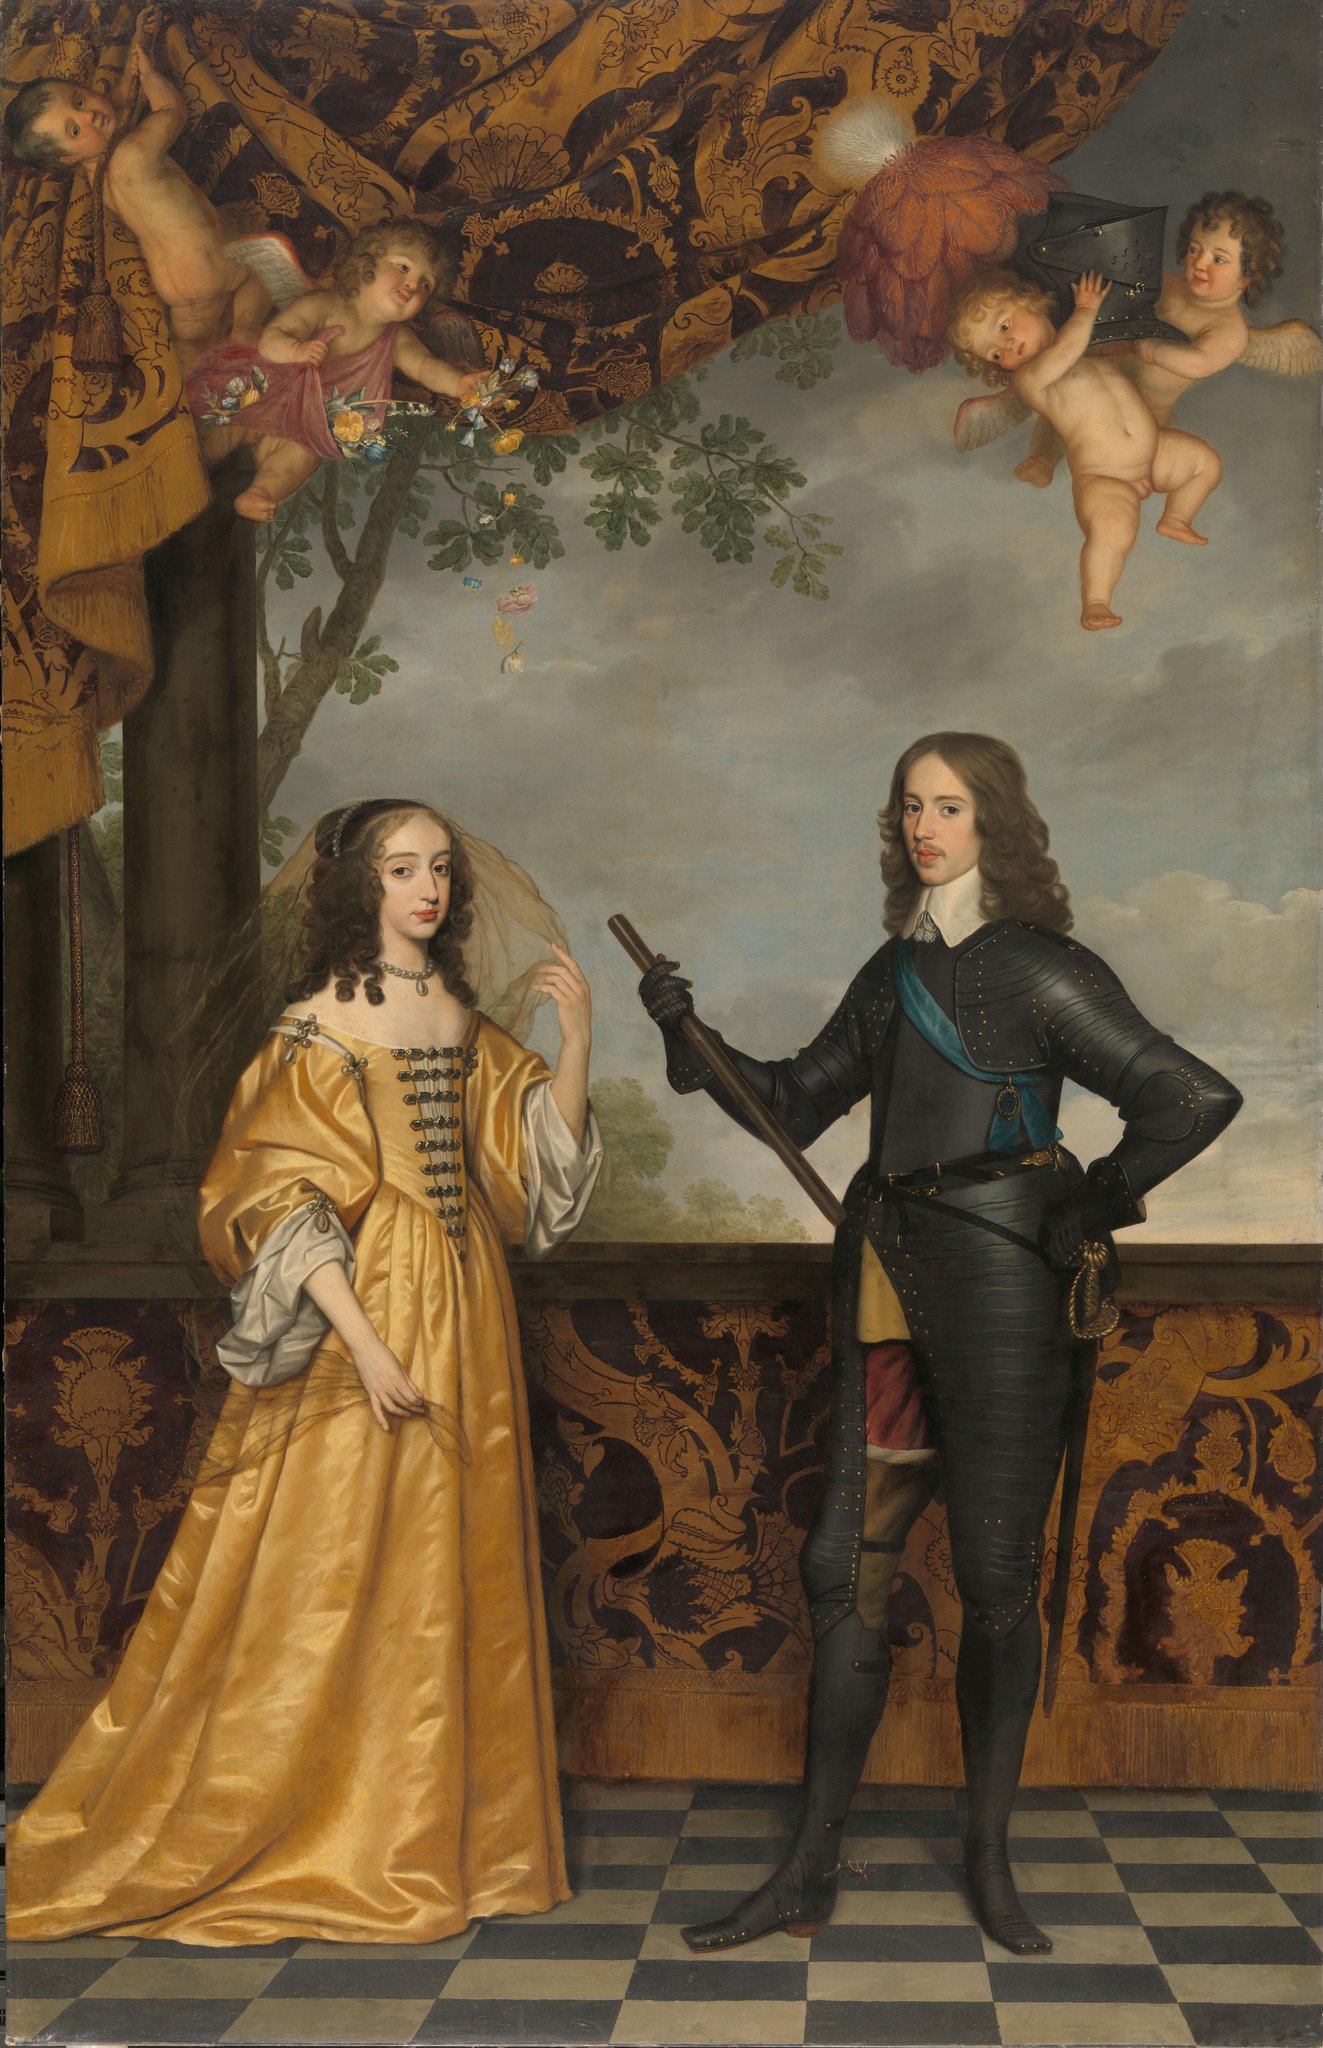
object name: painting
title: Portrait of Willem II (1626-1650), Prince of Orange, and his Wife Mary Stuart (1631-1660)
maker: gerard van honthorst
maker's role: draughtsman, painter, print maker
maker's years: 1592-1656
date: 1647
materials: canvas, oil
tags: william ii (prince of orange), mary henrietta stuart, historical persons - bb - woman, historical persons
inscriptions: signature and date, centre left, on the balustrade (G and H ligated): ‘GHonthorst / 1647’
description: Portret van Willem II, prins van Oranje, met zijn echtgenote Maria Stuart. Beiden zijn ten voeten uit voorgesteld, staande op een balkon. De prins in wapenrusting met commandostaf in de rechterhand. In het gordijn linksboven spelen vier putti, twee met de helm van de prins, één strooit met bloemen. Behoort bij de portretten: SK-A-874 en SK-A-873.